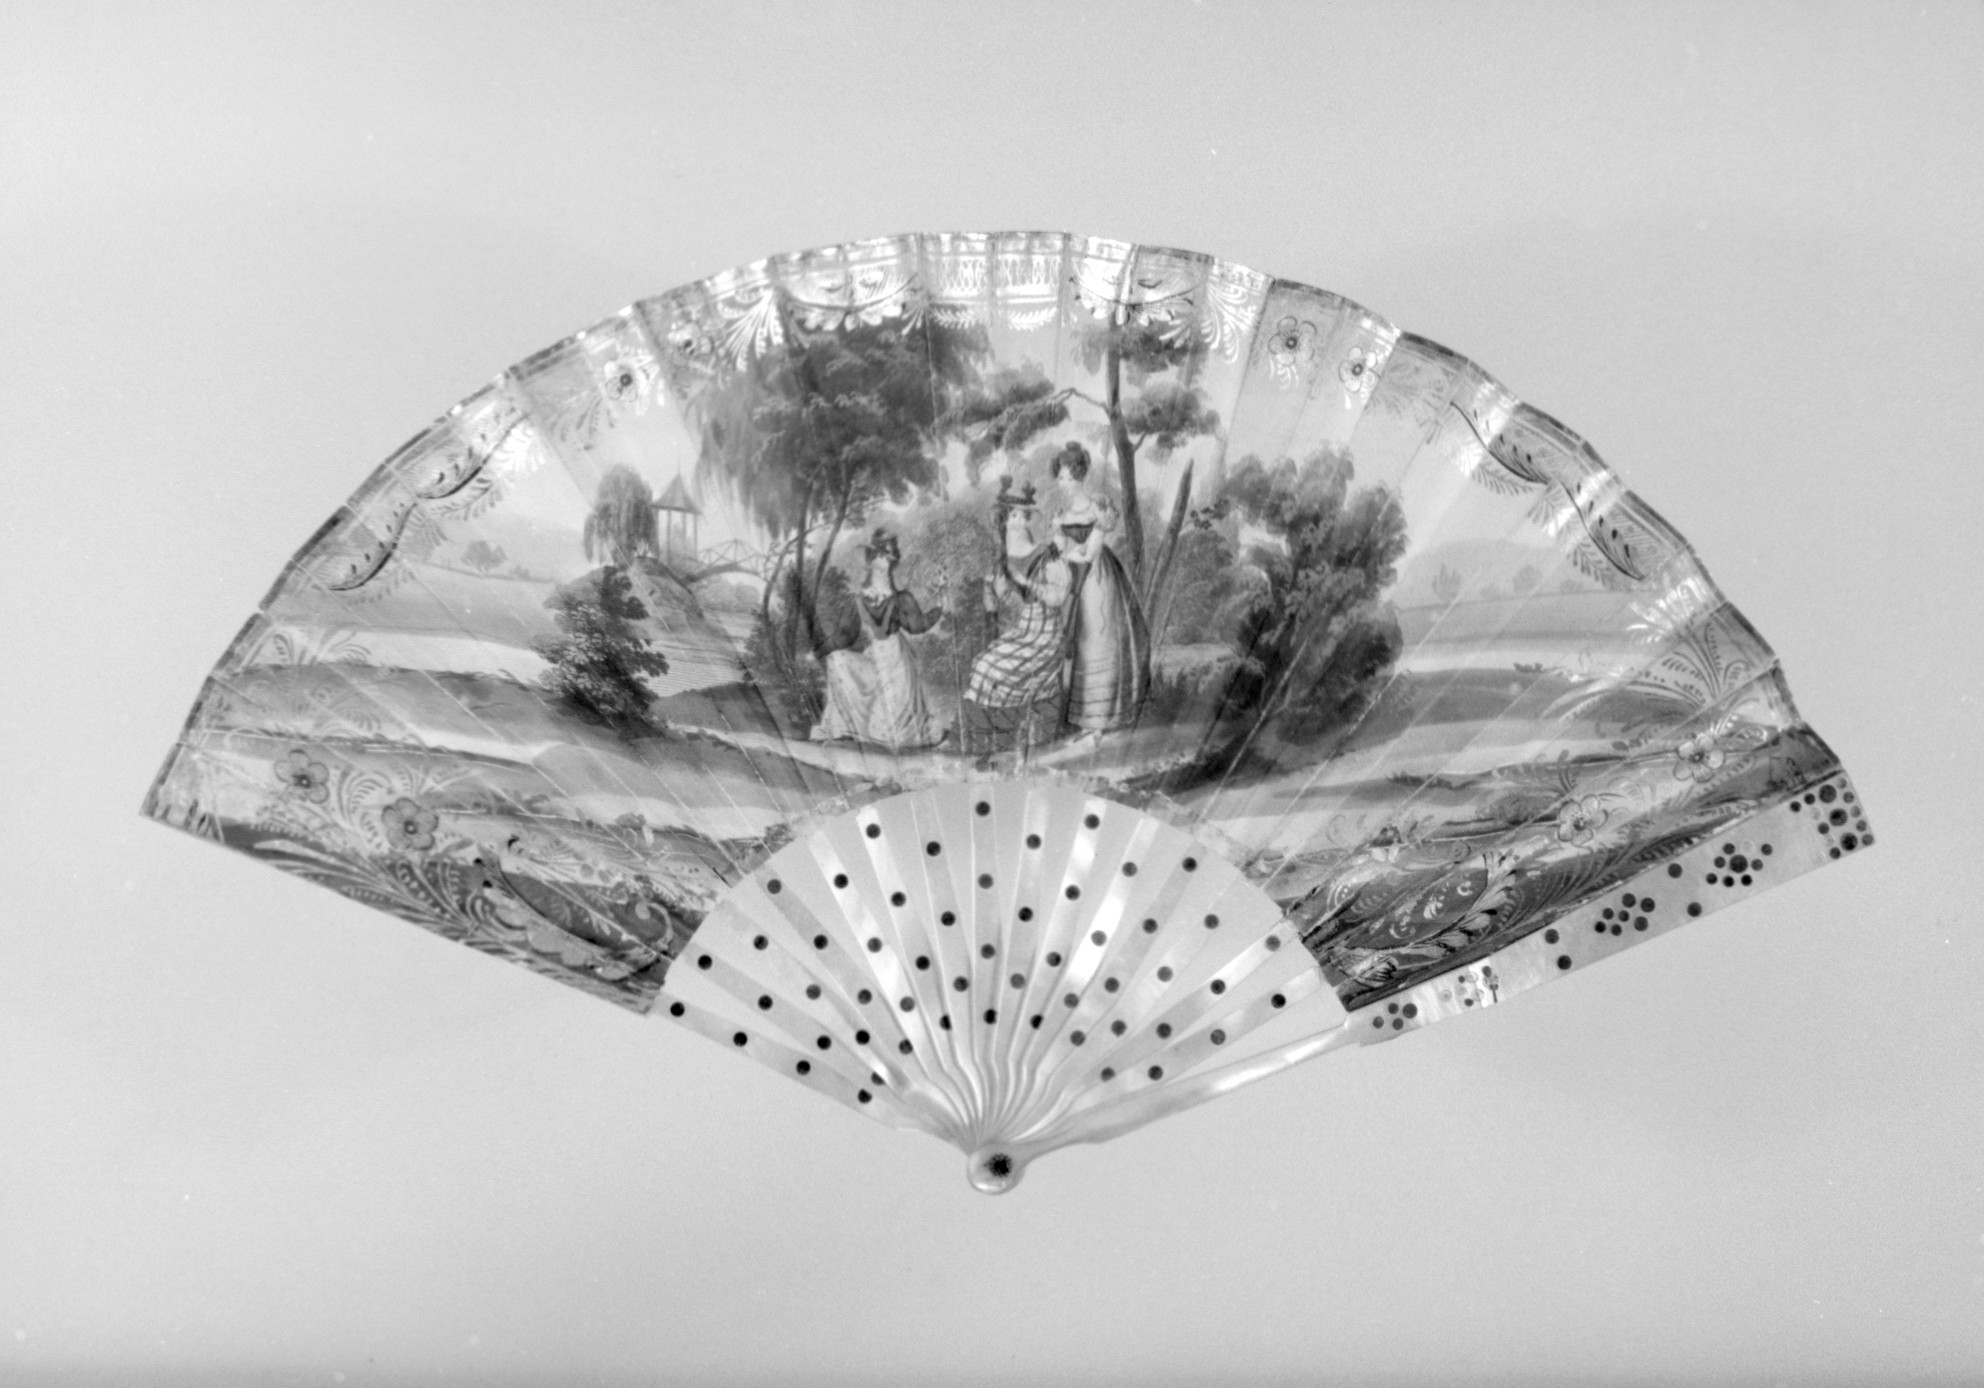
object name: fan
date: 1830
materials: gilt, glass, mother of pearl, paint, paper, steel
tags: women